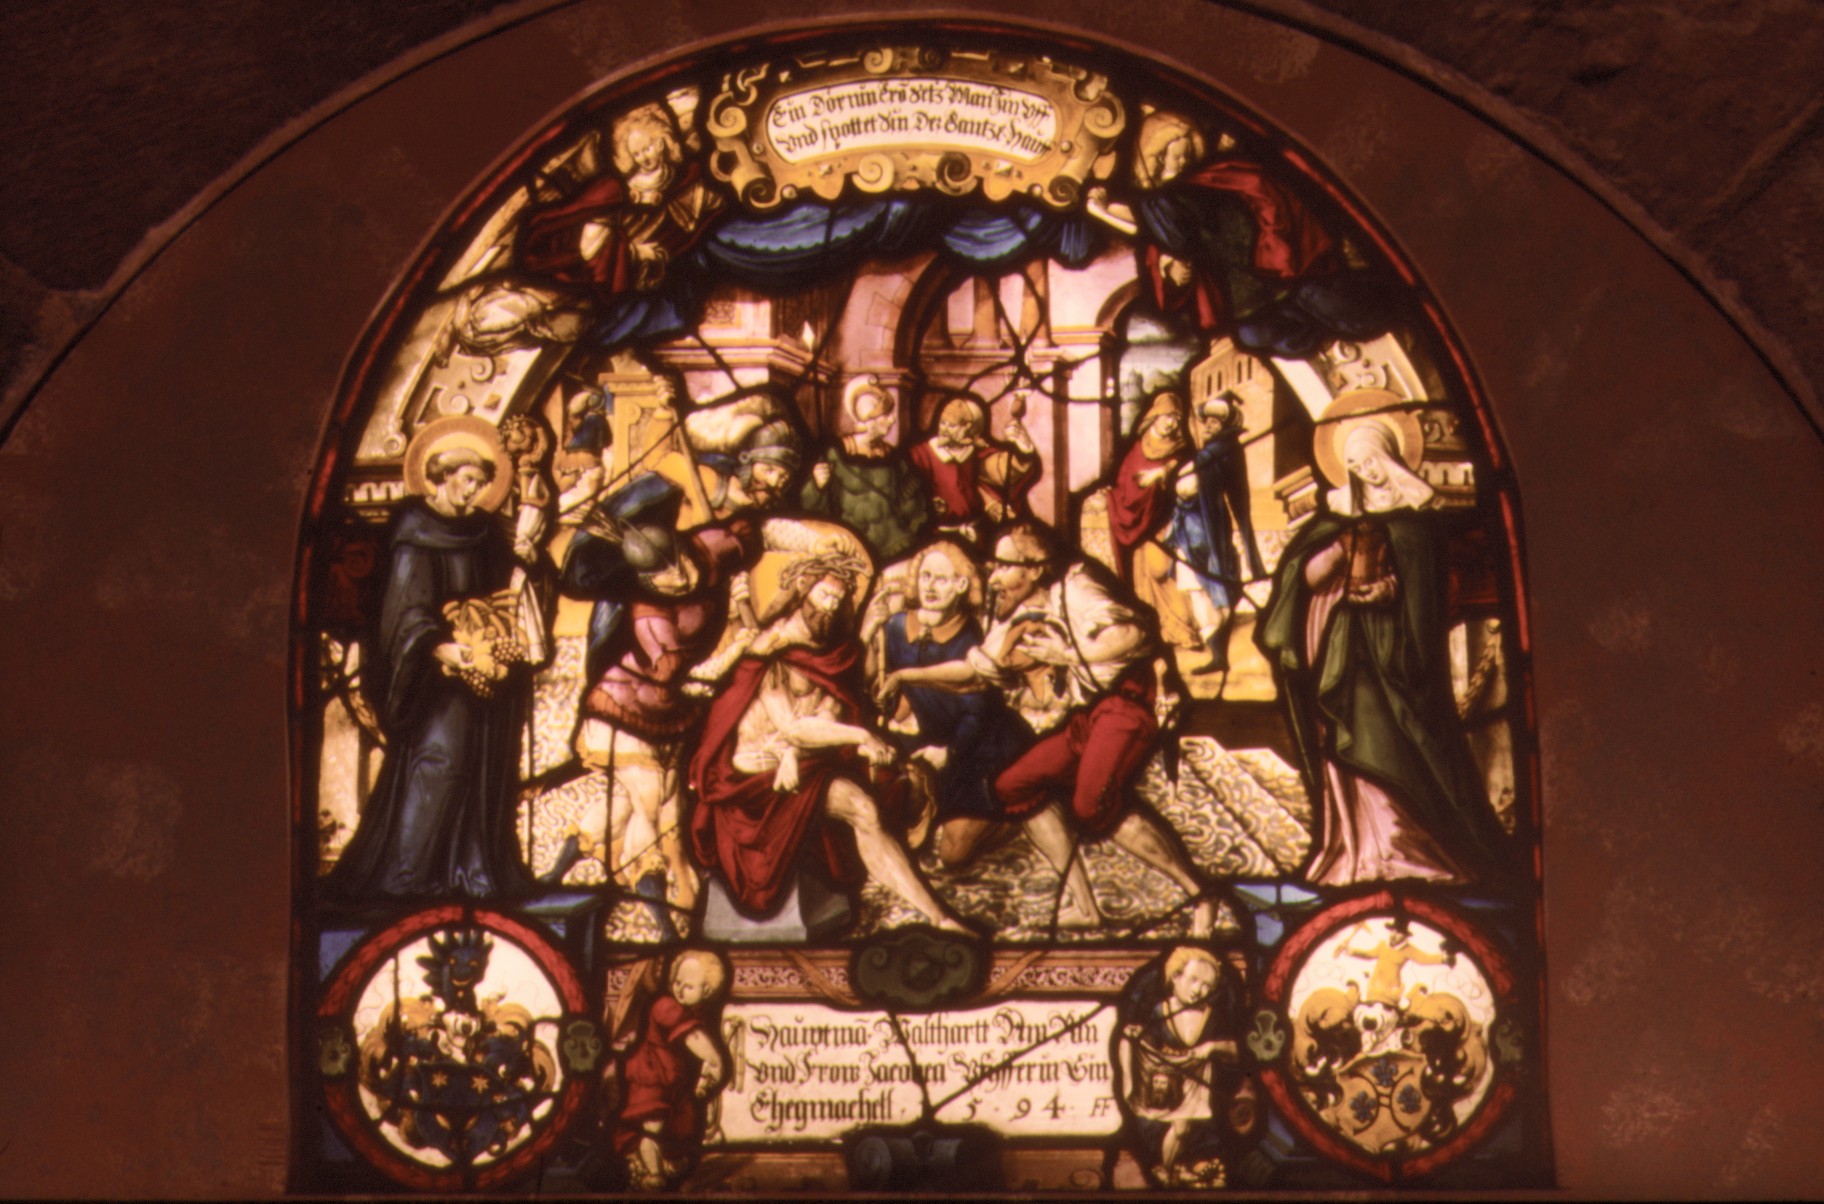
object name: panel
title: The Mocking of Christ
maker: franz fallenter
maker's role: artist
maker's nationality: german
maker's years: 1550-1616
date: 1594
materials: glass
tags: men,women,angels,christ